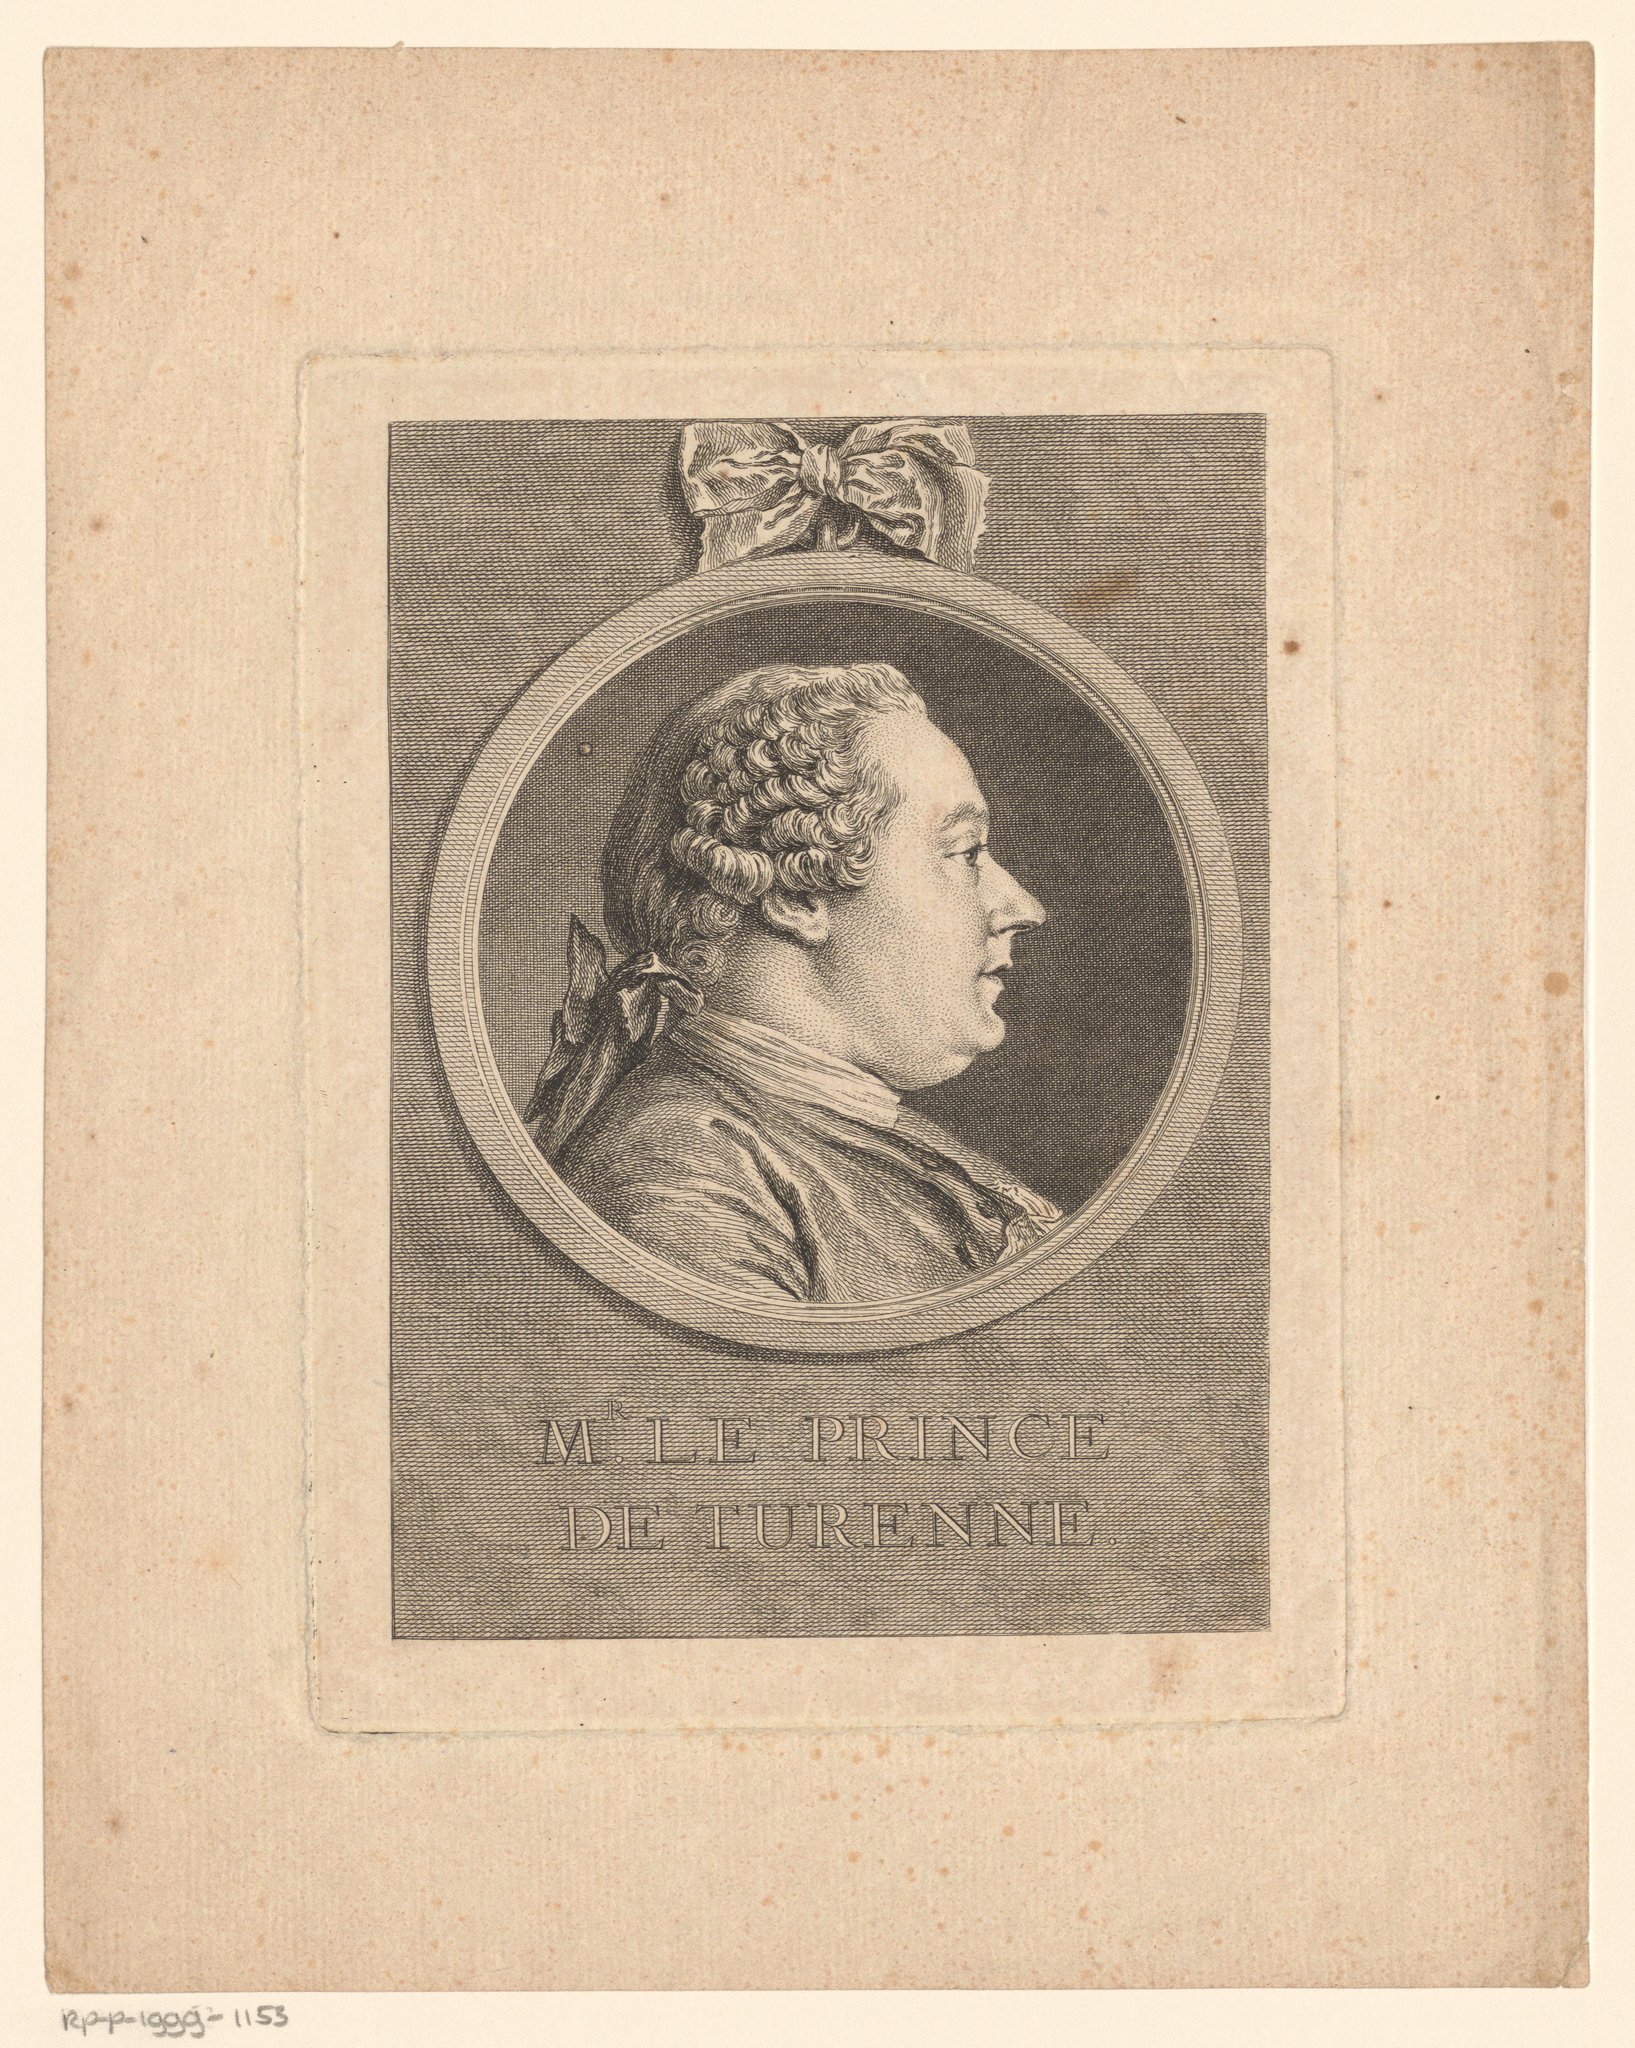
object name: print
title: Portret van Godefroy de La Tour d'Auvergne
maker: charles nicolas cochin (ii)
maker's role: draughtsman, print maker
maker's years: 1715-1790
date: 1760-1790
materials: paper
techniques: engraving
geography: paris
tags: historical persons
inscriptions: collector's mark: Lugt 2228, collector's mark: Lugt 2760